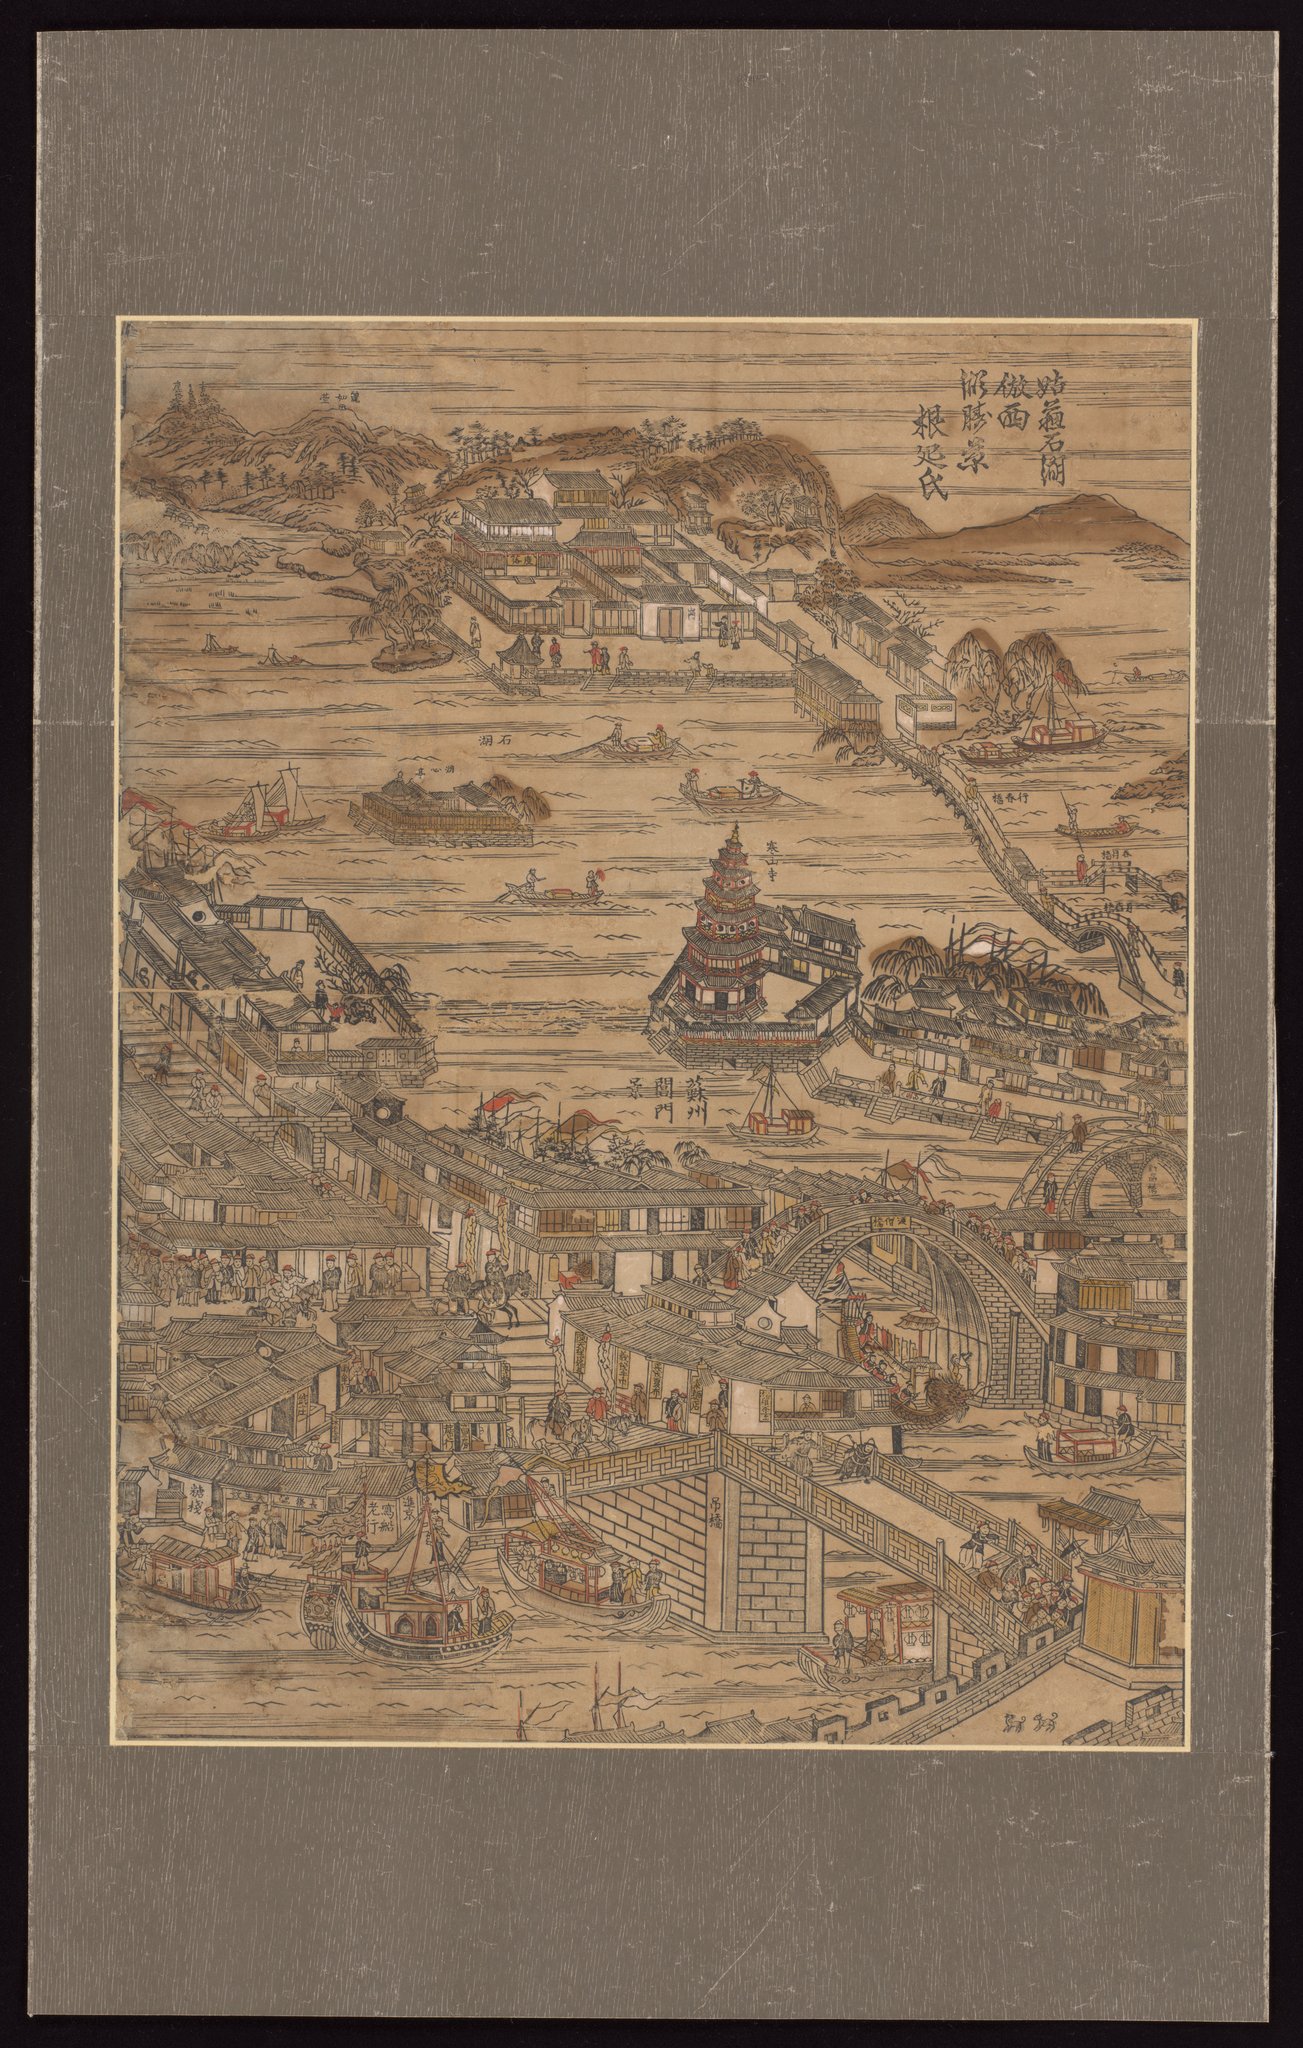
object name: print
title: Stone Lake In Suzhou : An Emulation of ‘Famous Scenes of West Lake’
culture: chinese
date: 1736-1795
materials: ink, paper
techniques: hand coloring, woodblock print